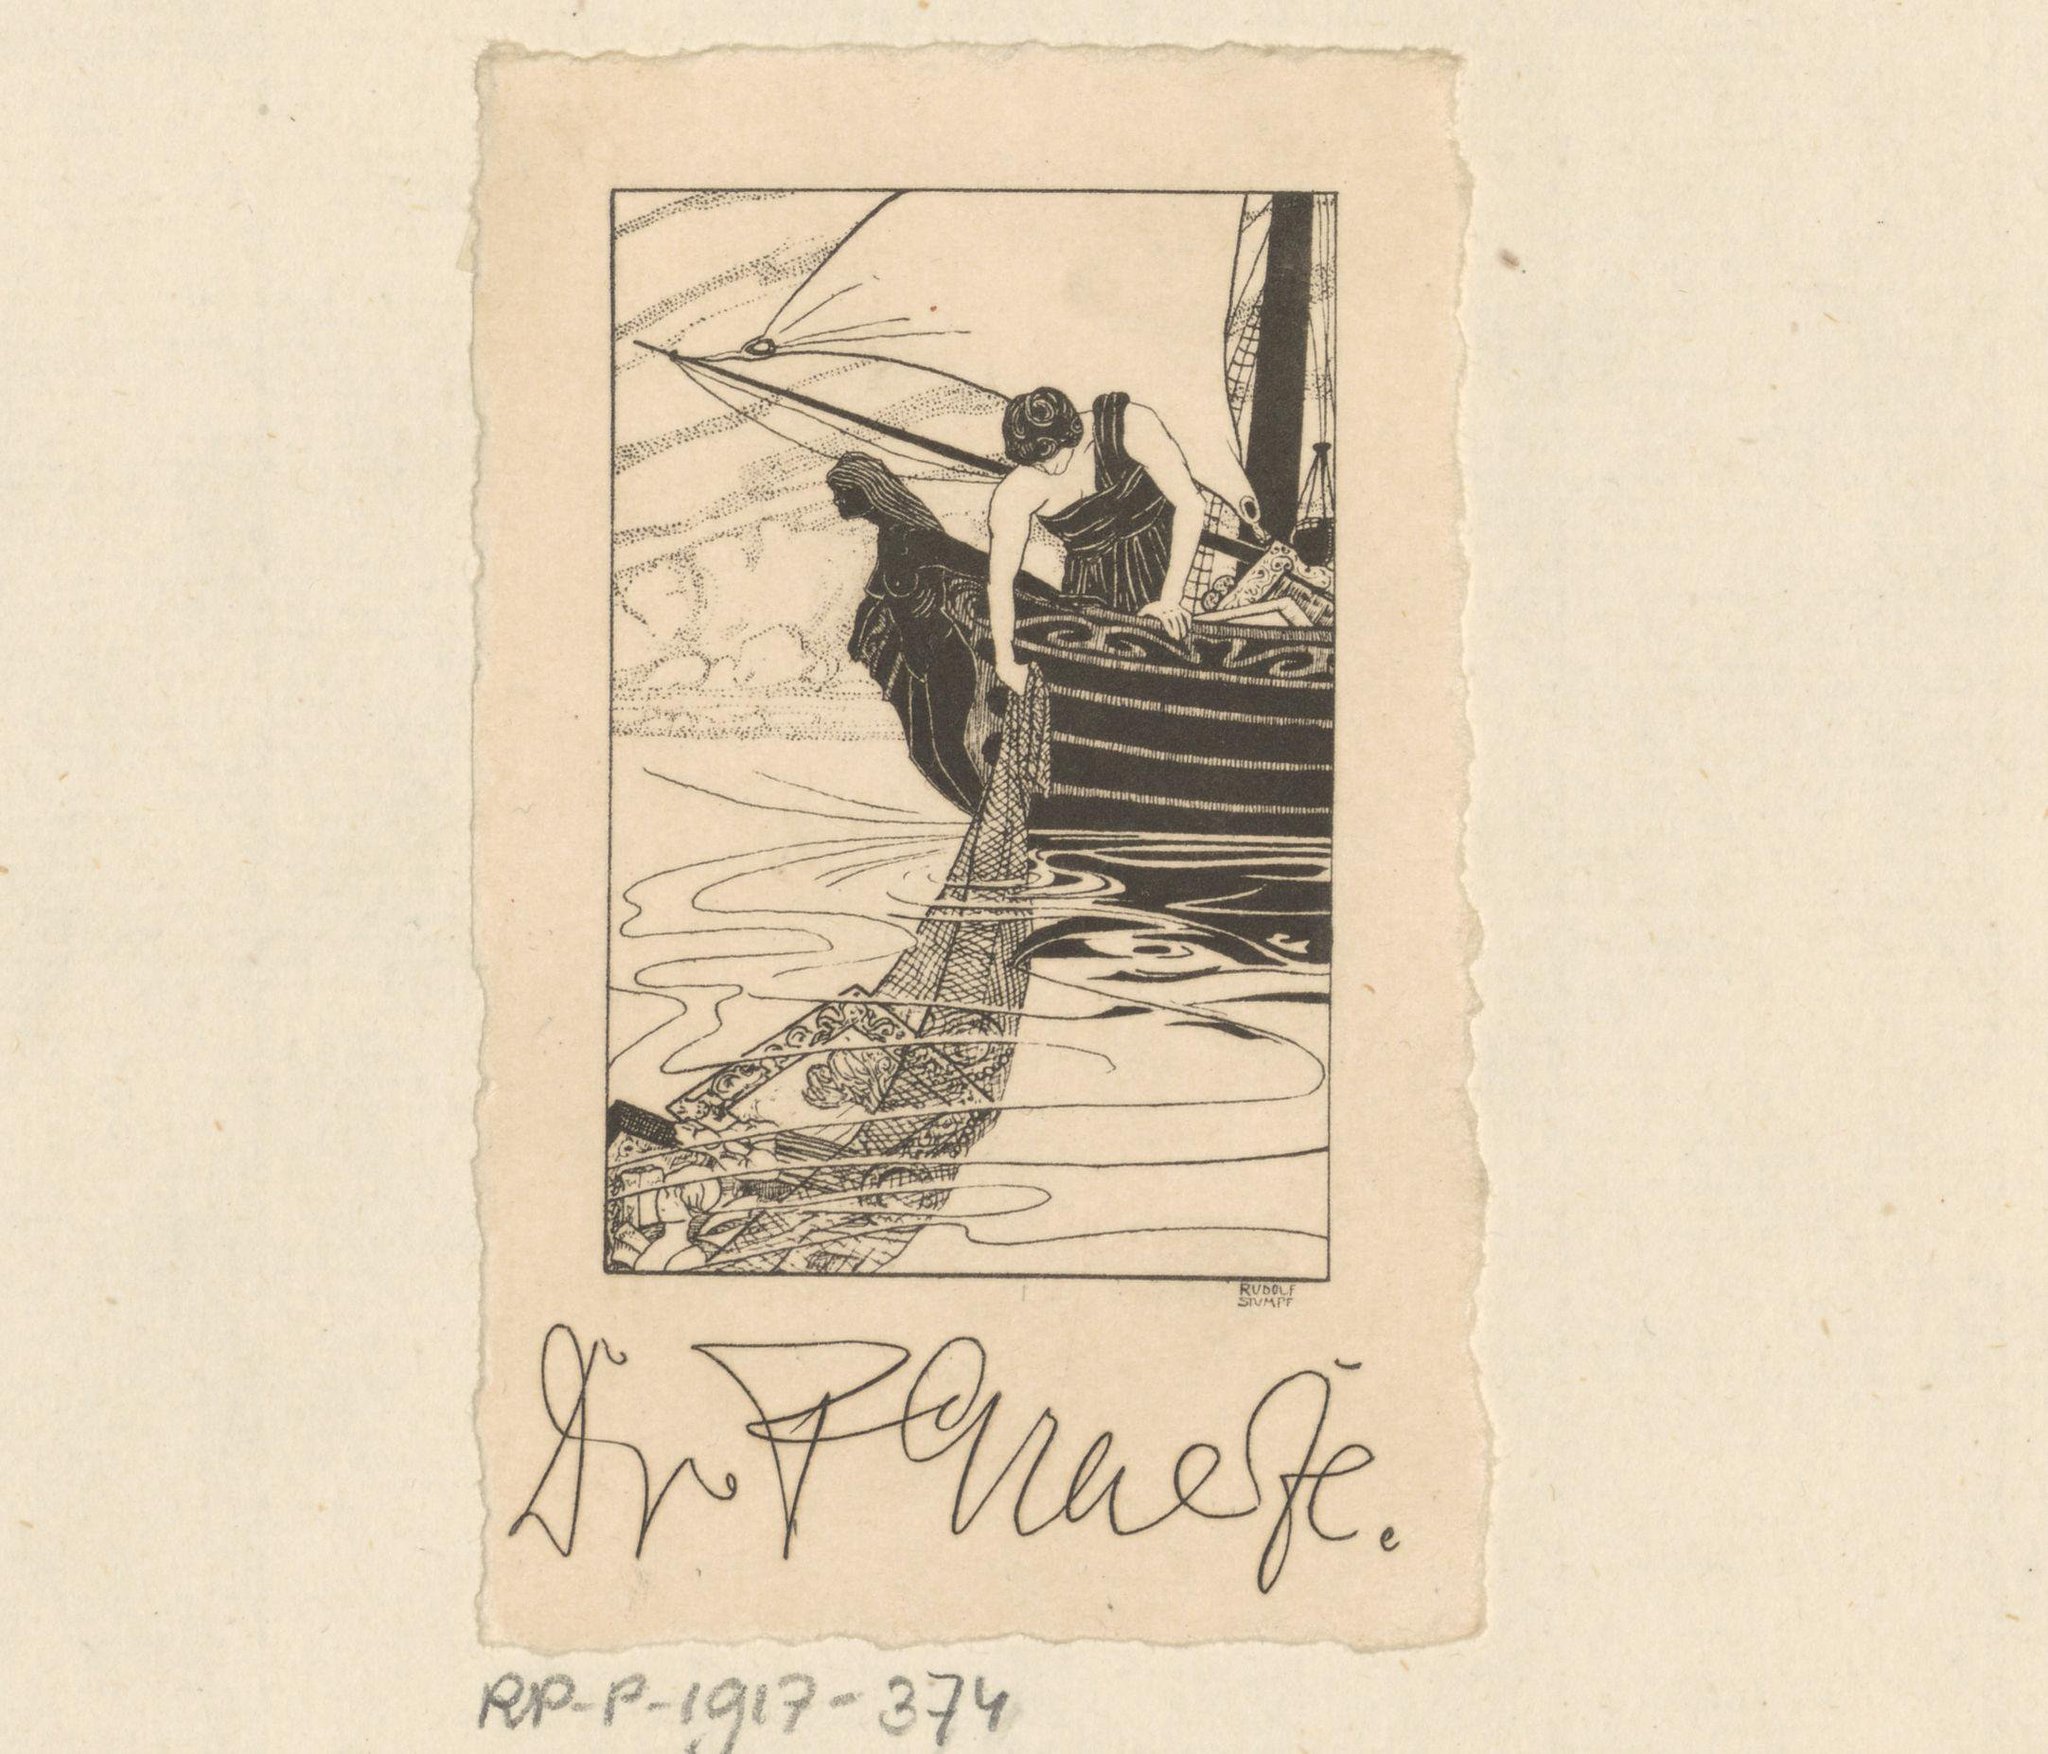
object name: bookplate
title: Ex libris van C. Graefe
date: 1880-1917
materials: paper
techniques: printing block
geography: germany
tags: standing figure, sailing-ship, sailing-boat, fishing net, woman (showing herself) undressed, quasi-nude, picture, painting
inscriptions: collector's mark: Lugt 2233